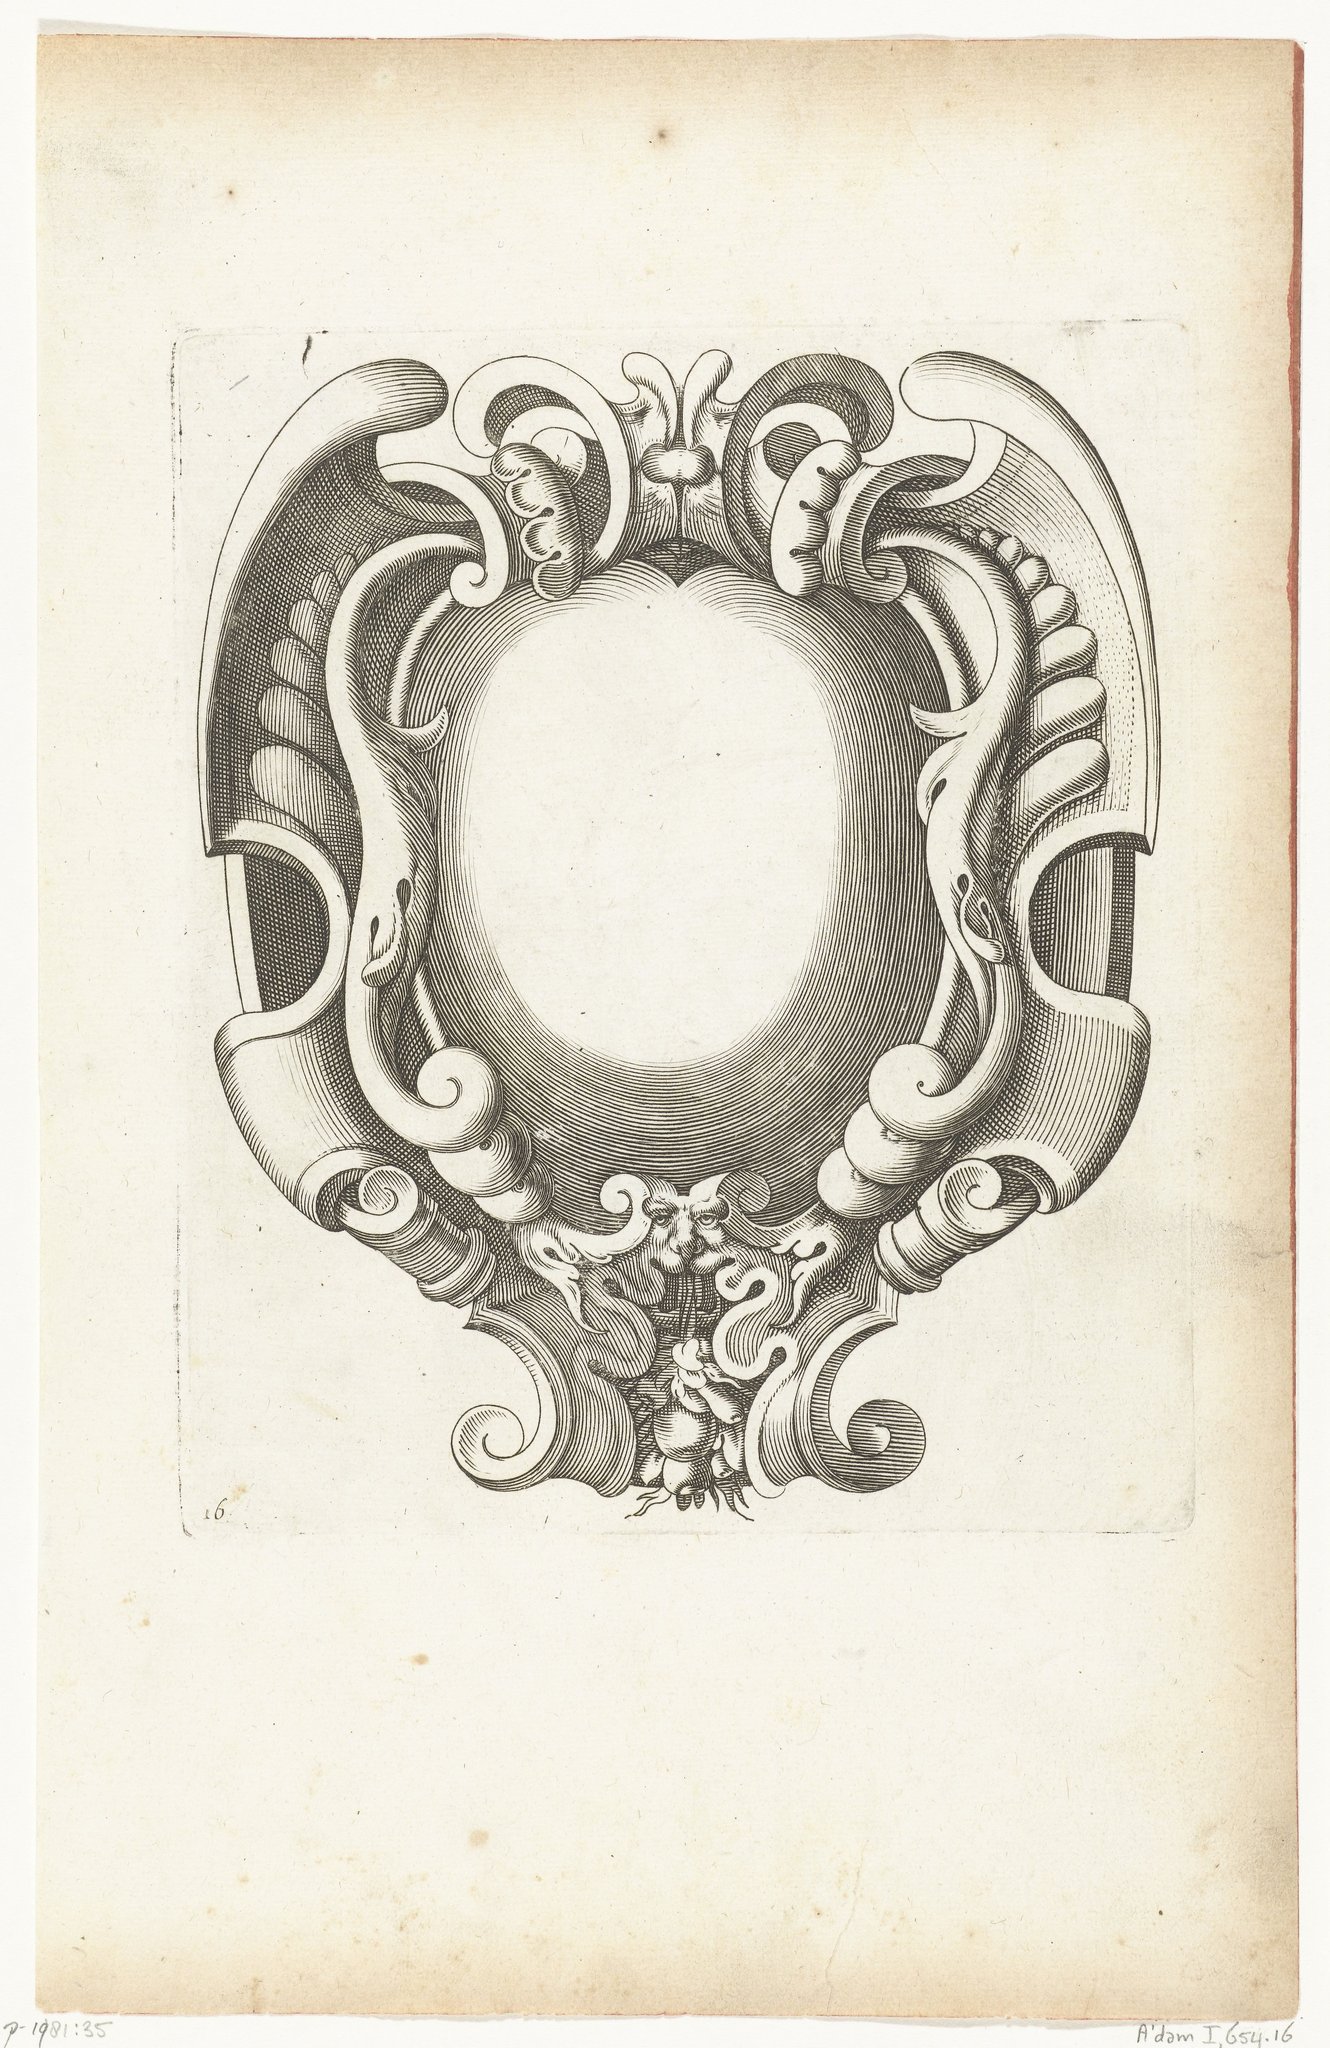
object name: ornament print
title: Cartouche met mascaron dat trosje vruchten in de mond heeft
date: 1613-1657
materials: paper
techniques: engraving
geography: france